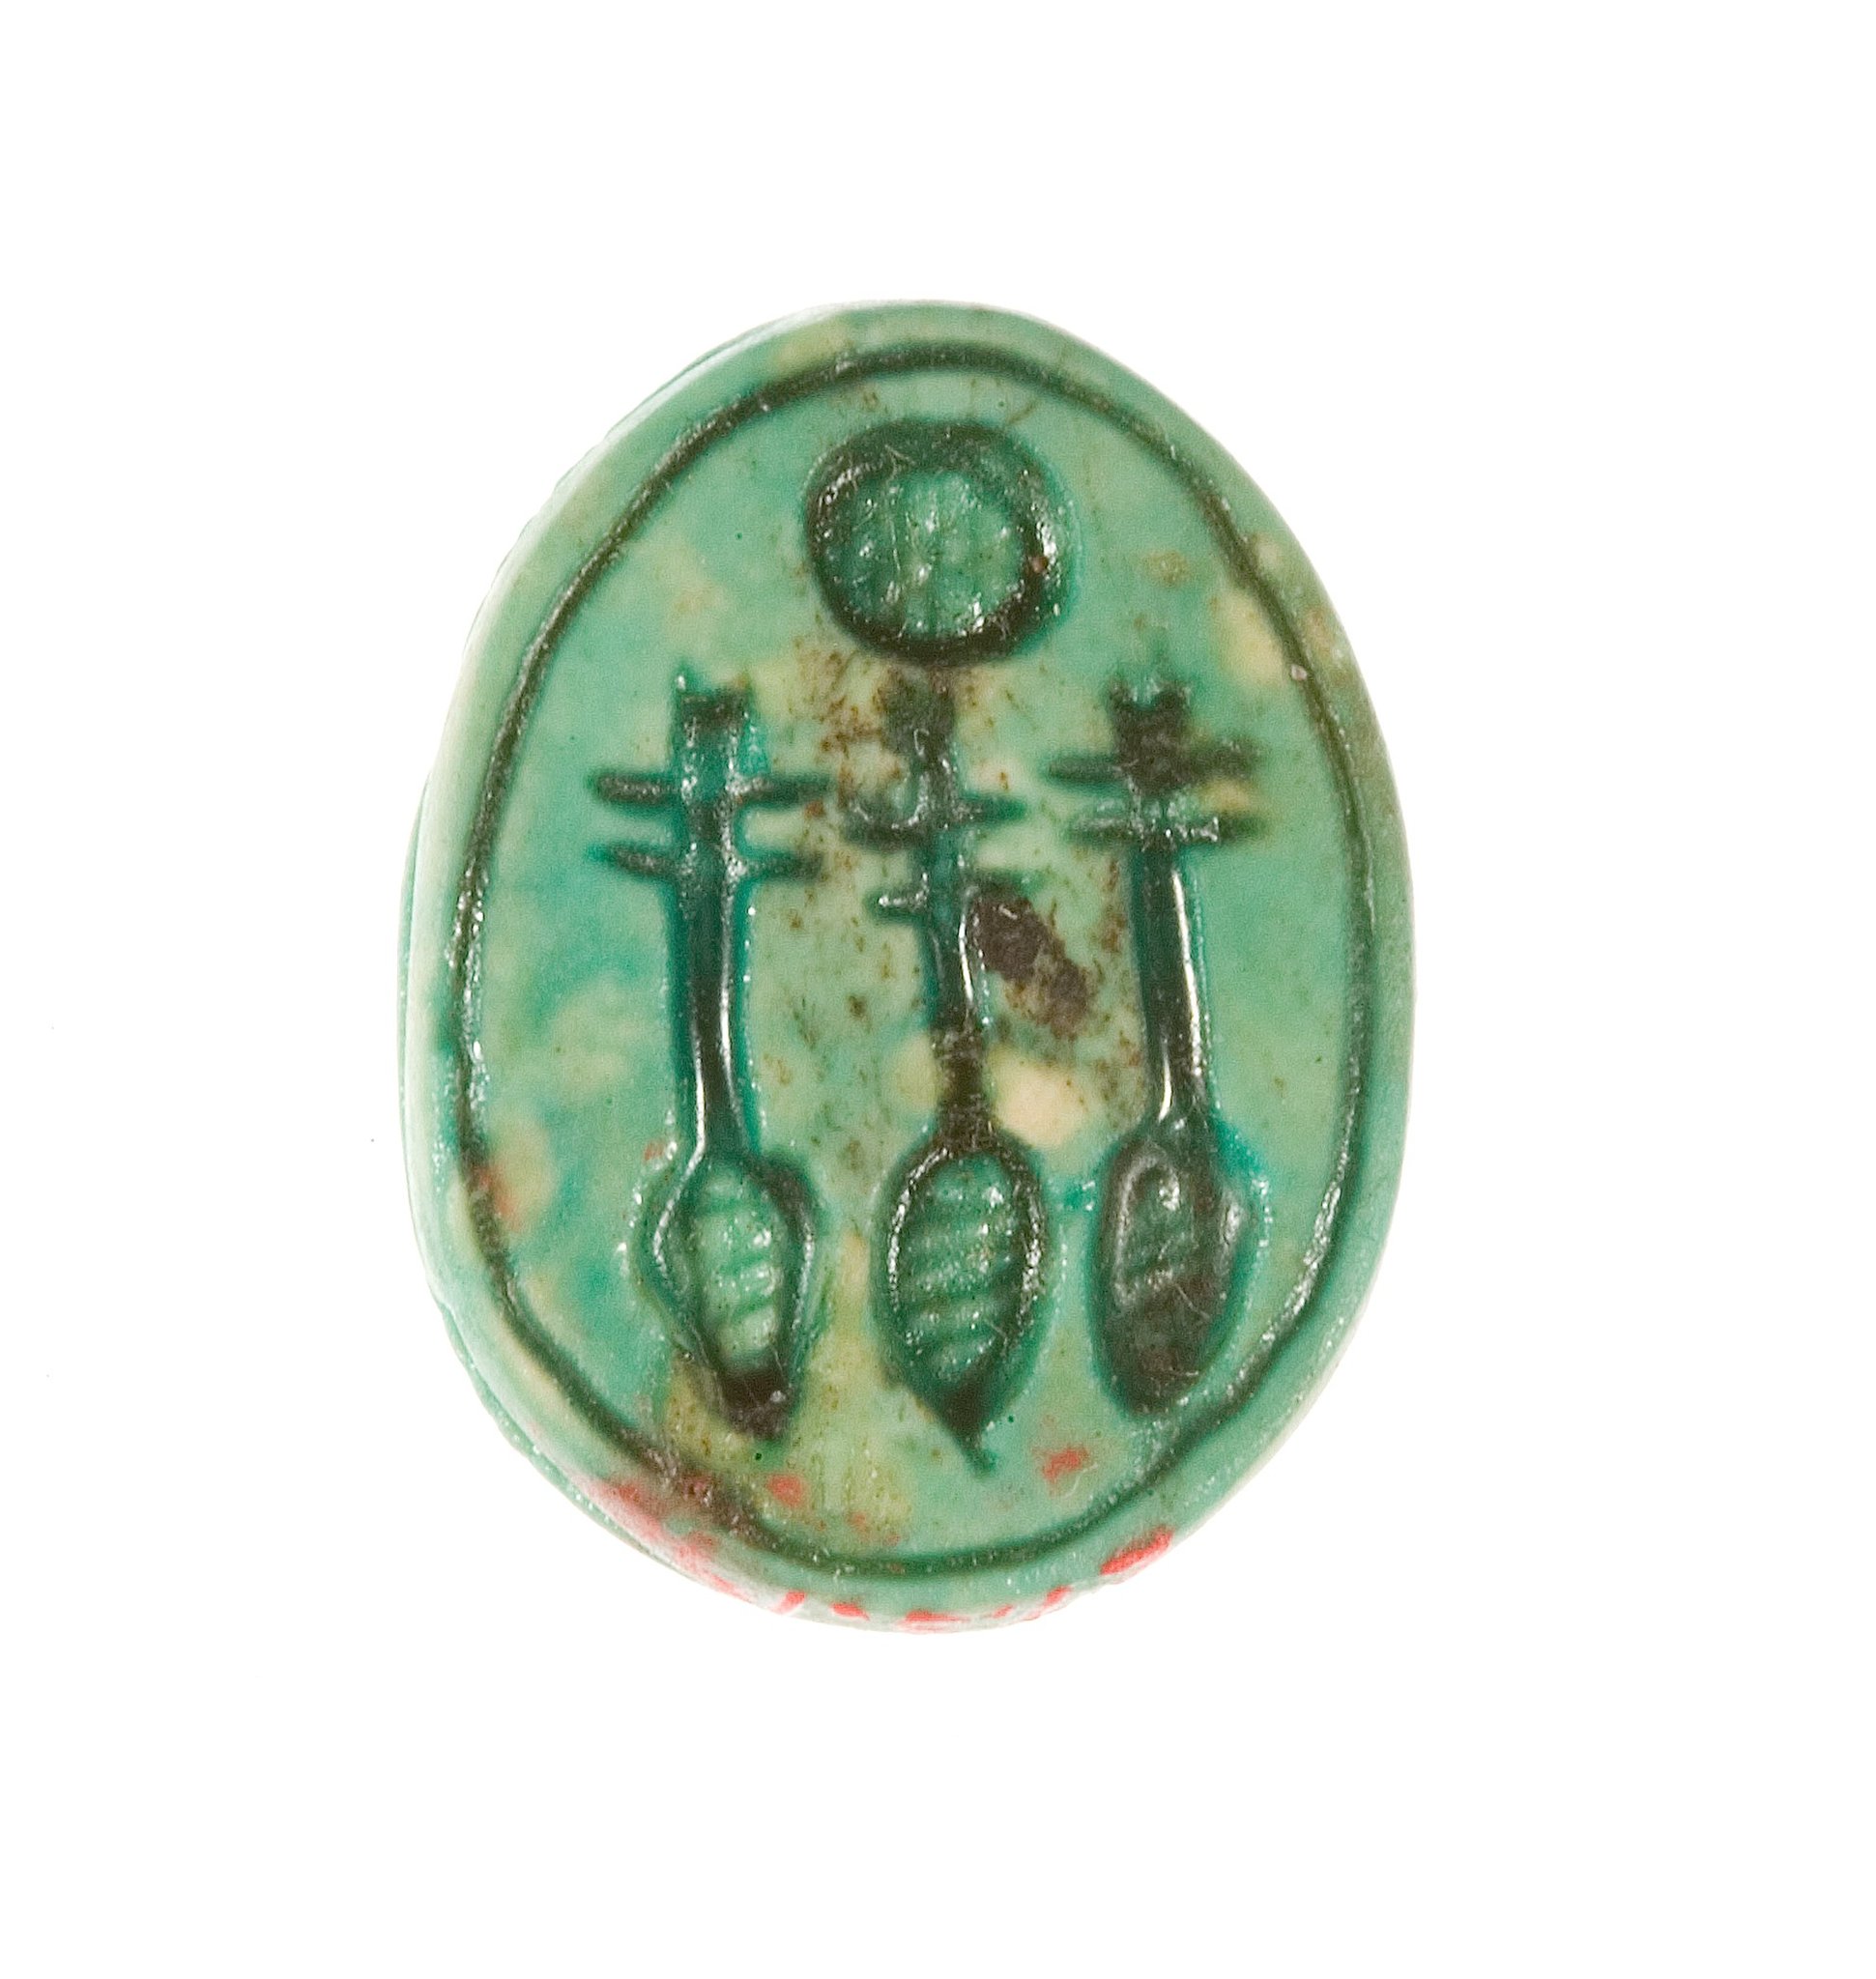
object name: scarab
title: Scarabs Inscribed for Neferure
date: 1479-1458 BCE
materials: stone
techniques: glazing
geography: egypt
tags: hieroglyphs,scarabs